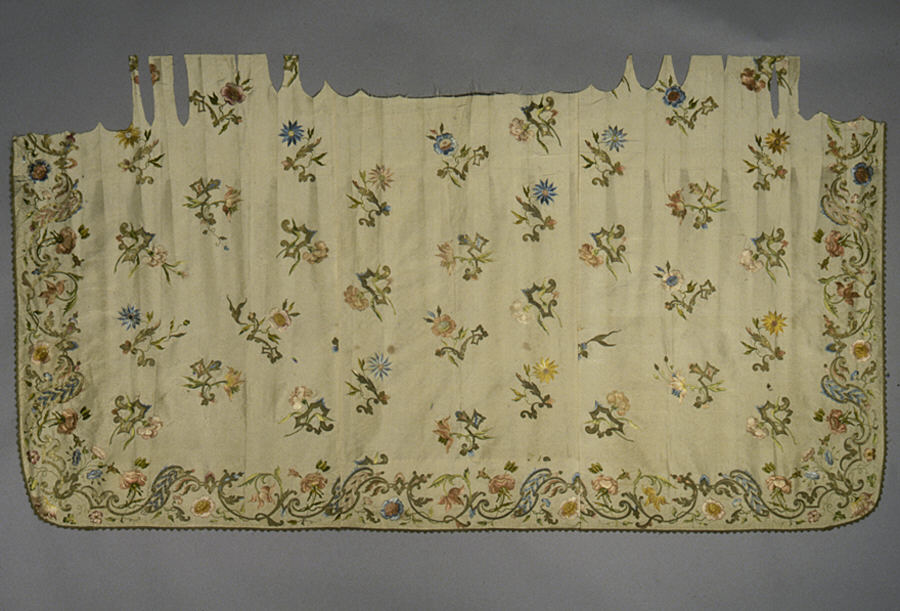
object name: panel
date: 1701-1800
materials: metal thread, silk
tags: flowers,leaves